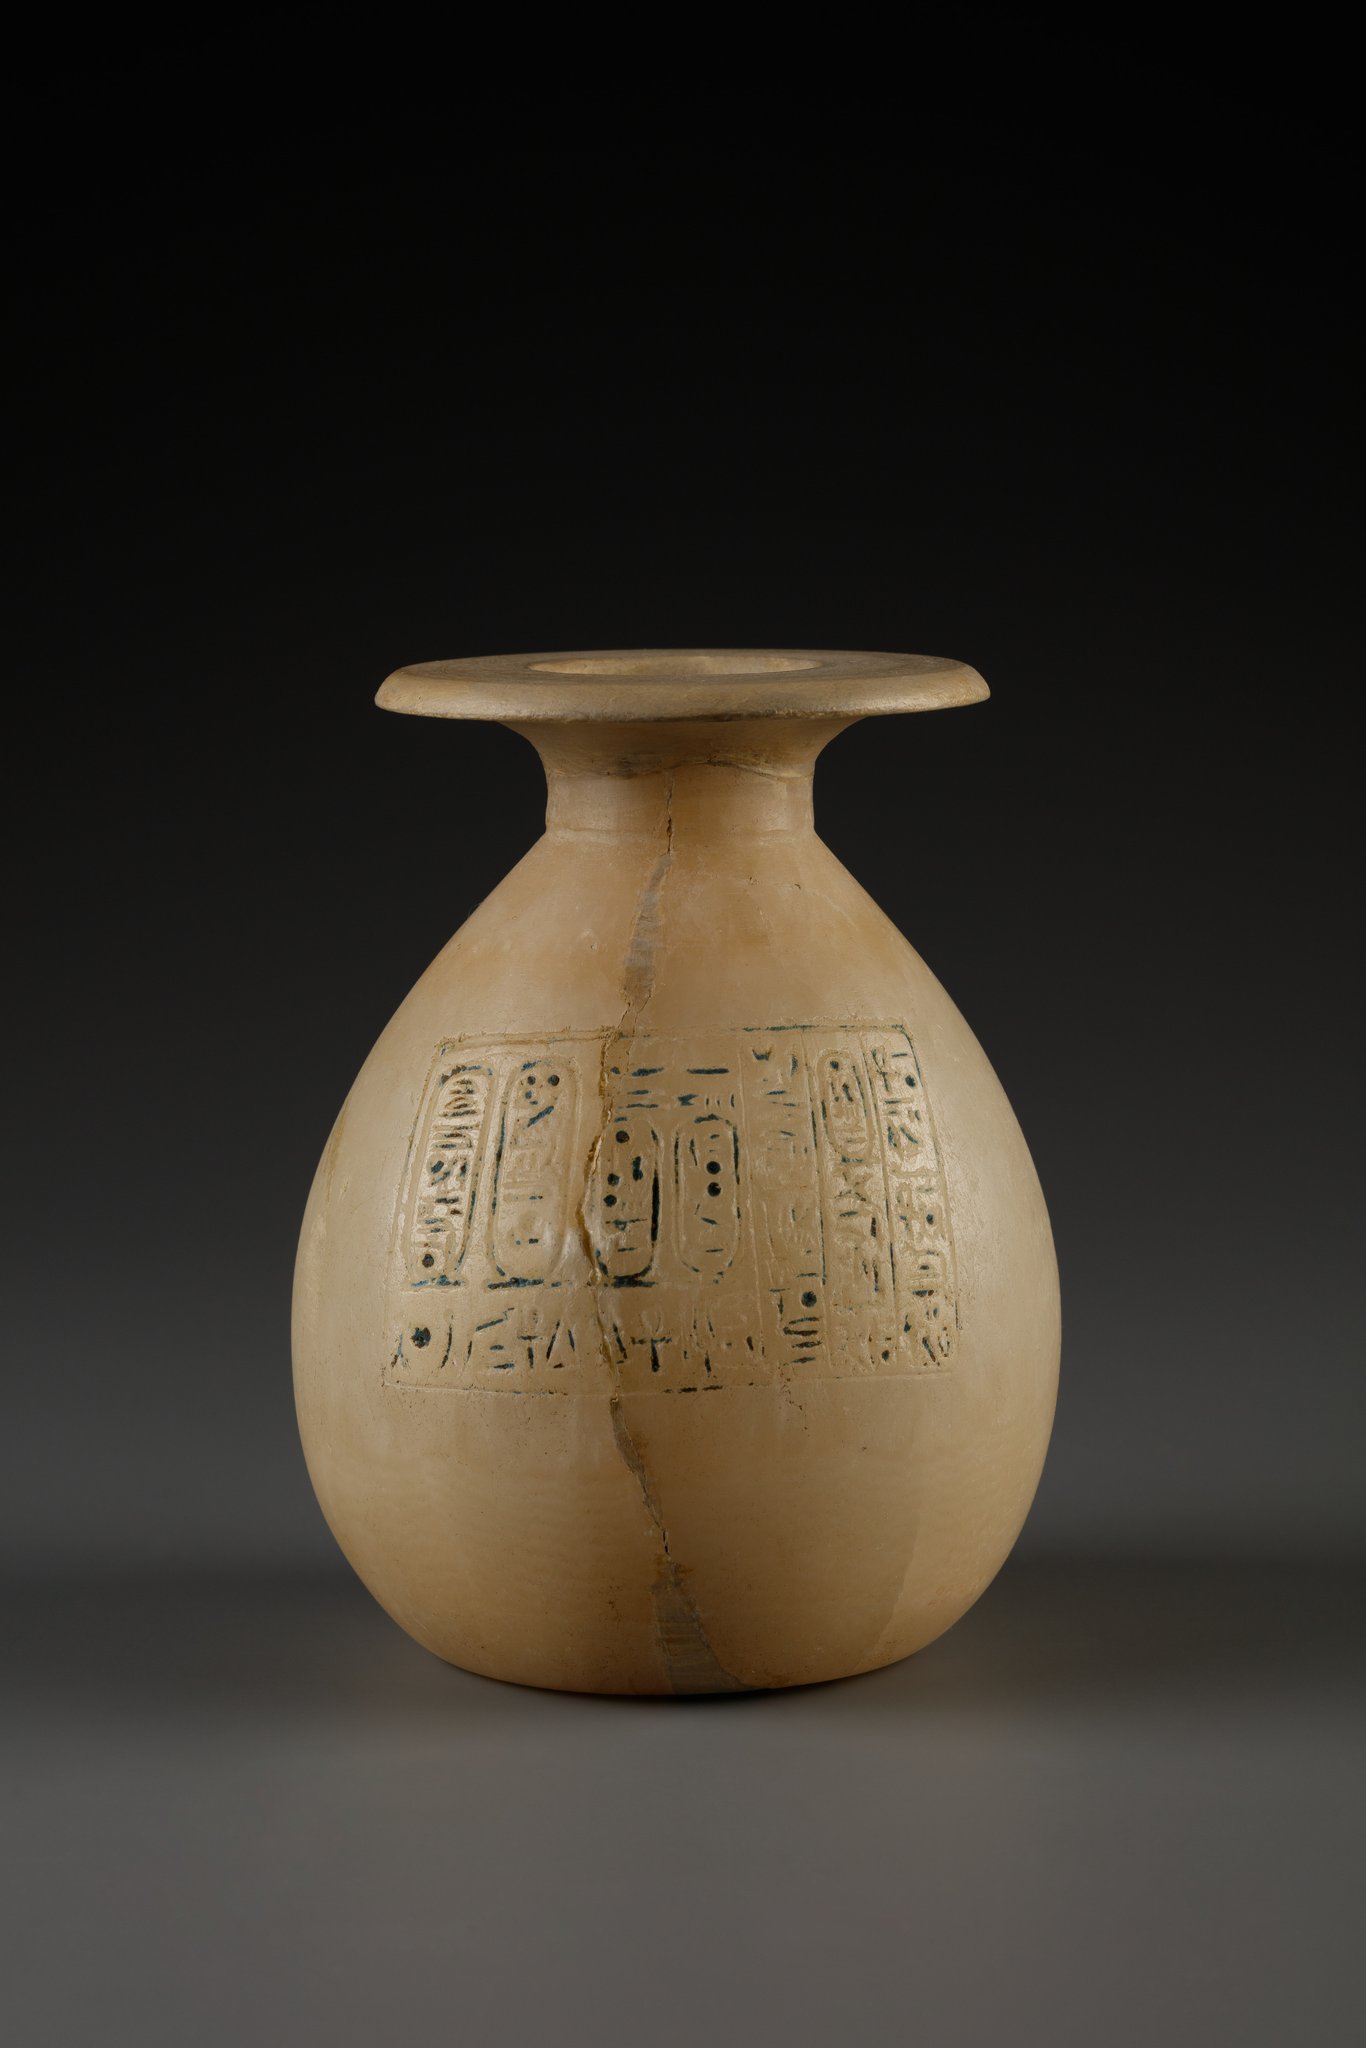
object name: vase, kiya, inscribed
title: Unguent Vase of Queen Kiya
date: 1353-1323 BCE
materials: stone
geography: egypt